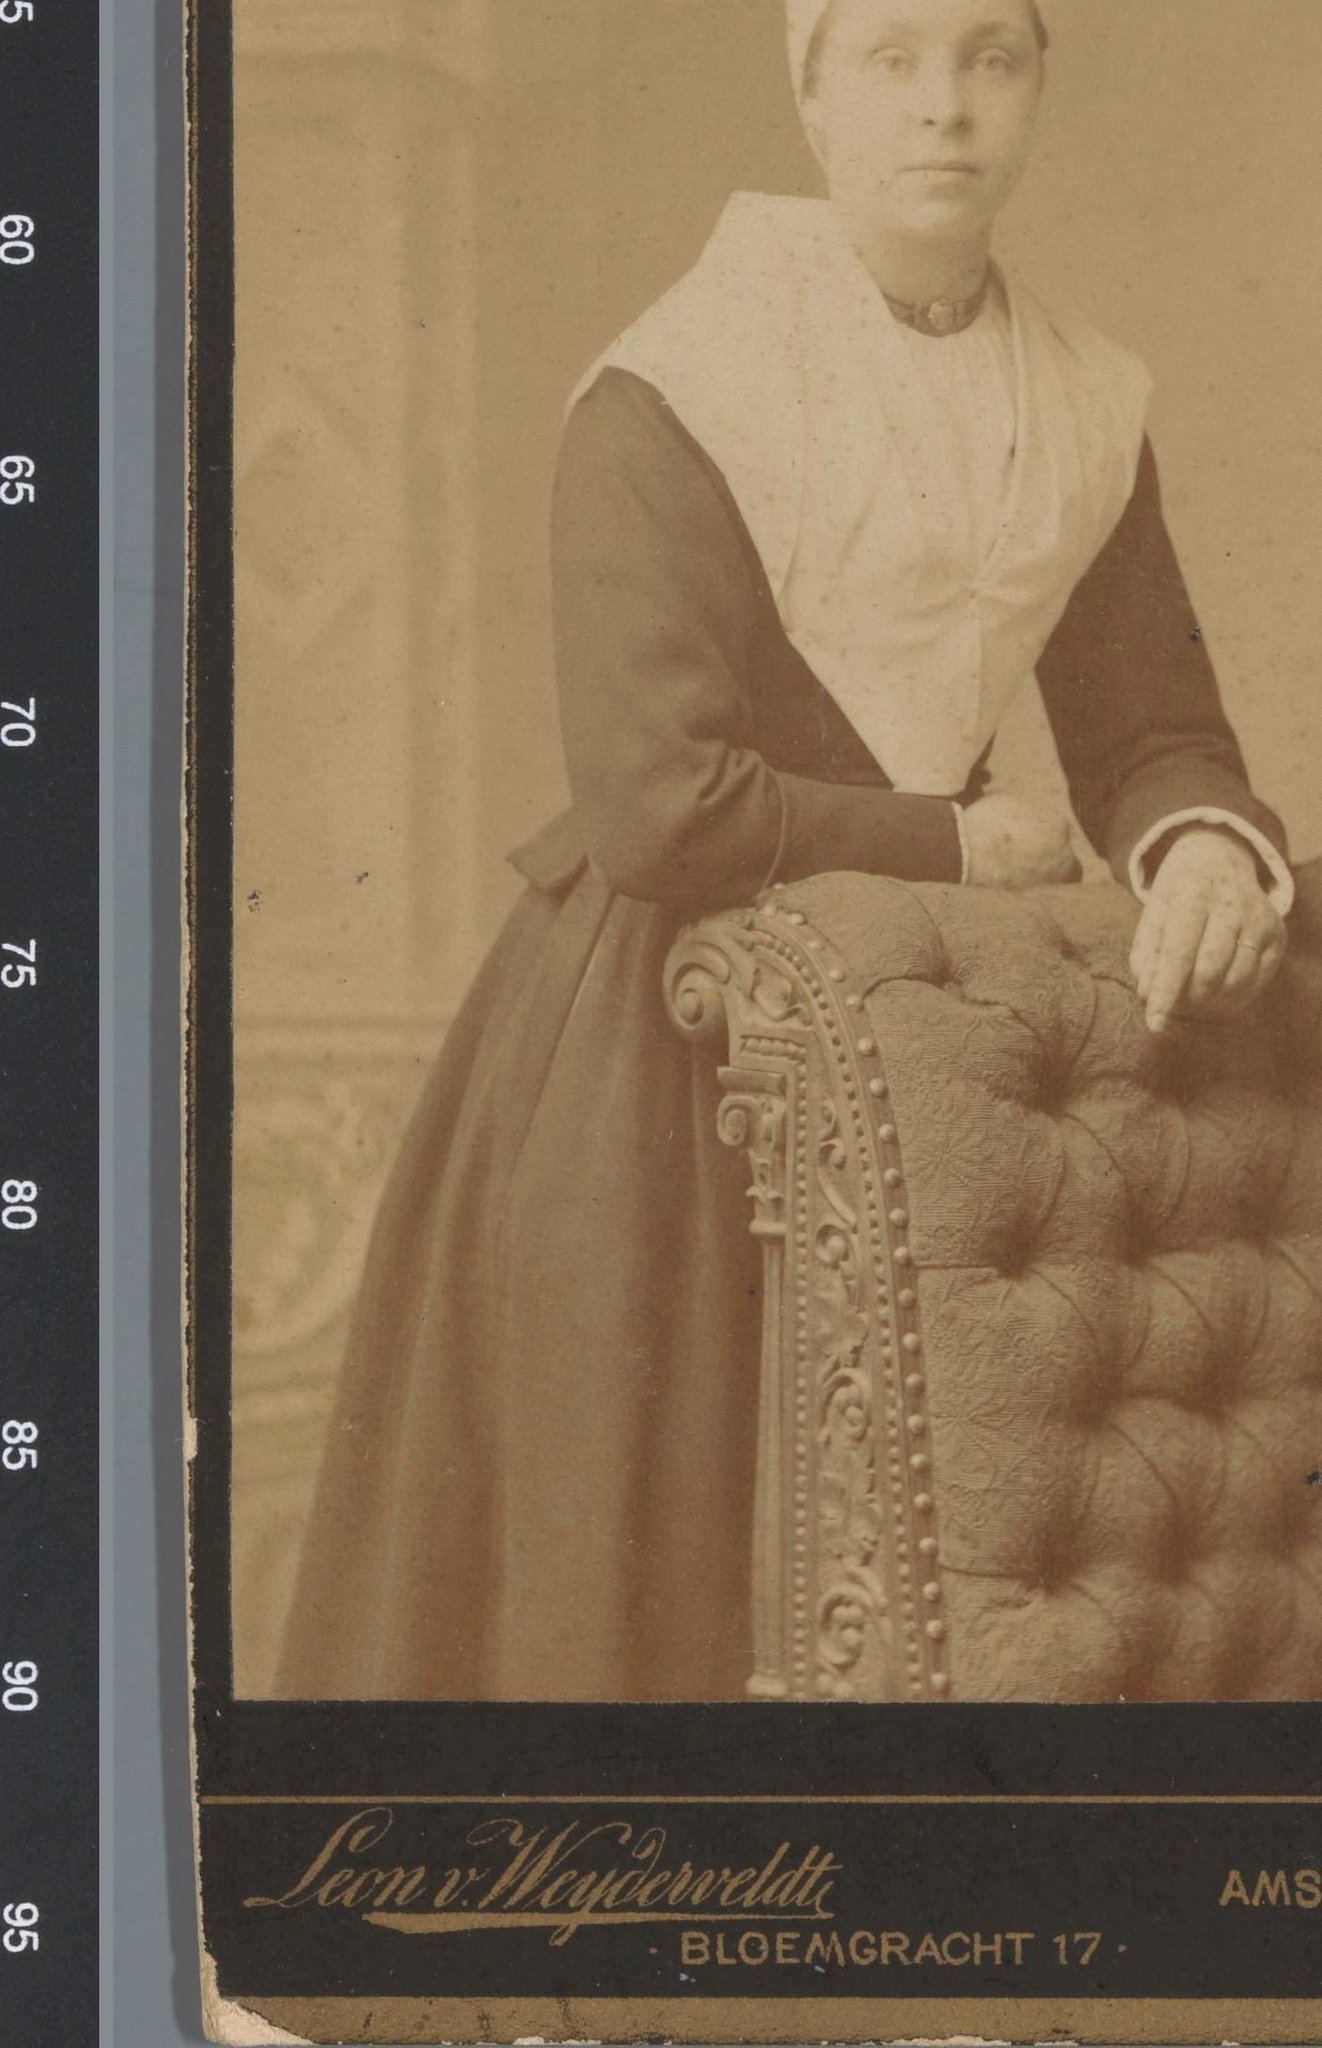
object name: carte de visite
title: Portret van een onbekende vrouw bij een stoel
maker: leon a. van weijderveldt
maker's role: fotograaf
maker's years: 1814-1888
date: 1868-1888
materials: cardboard, paper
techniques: albumen print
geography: amsterdam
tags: adult woman, anonymous historical person portrayed, amsterdam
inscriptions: inscription: ‘Leon v. Weyderveldt/ Amsterdam./ Bloemgracht 17’, inscription: ‘Leon v. Weyderveldt/ Amsterdam/ Bloemgracht/ 17./ b.d. Prinsengracht/ Specialiteit in Vergrootingen./ Bernhard Wachtl Wien.’